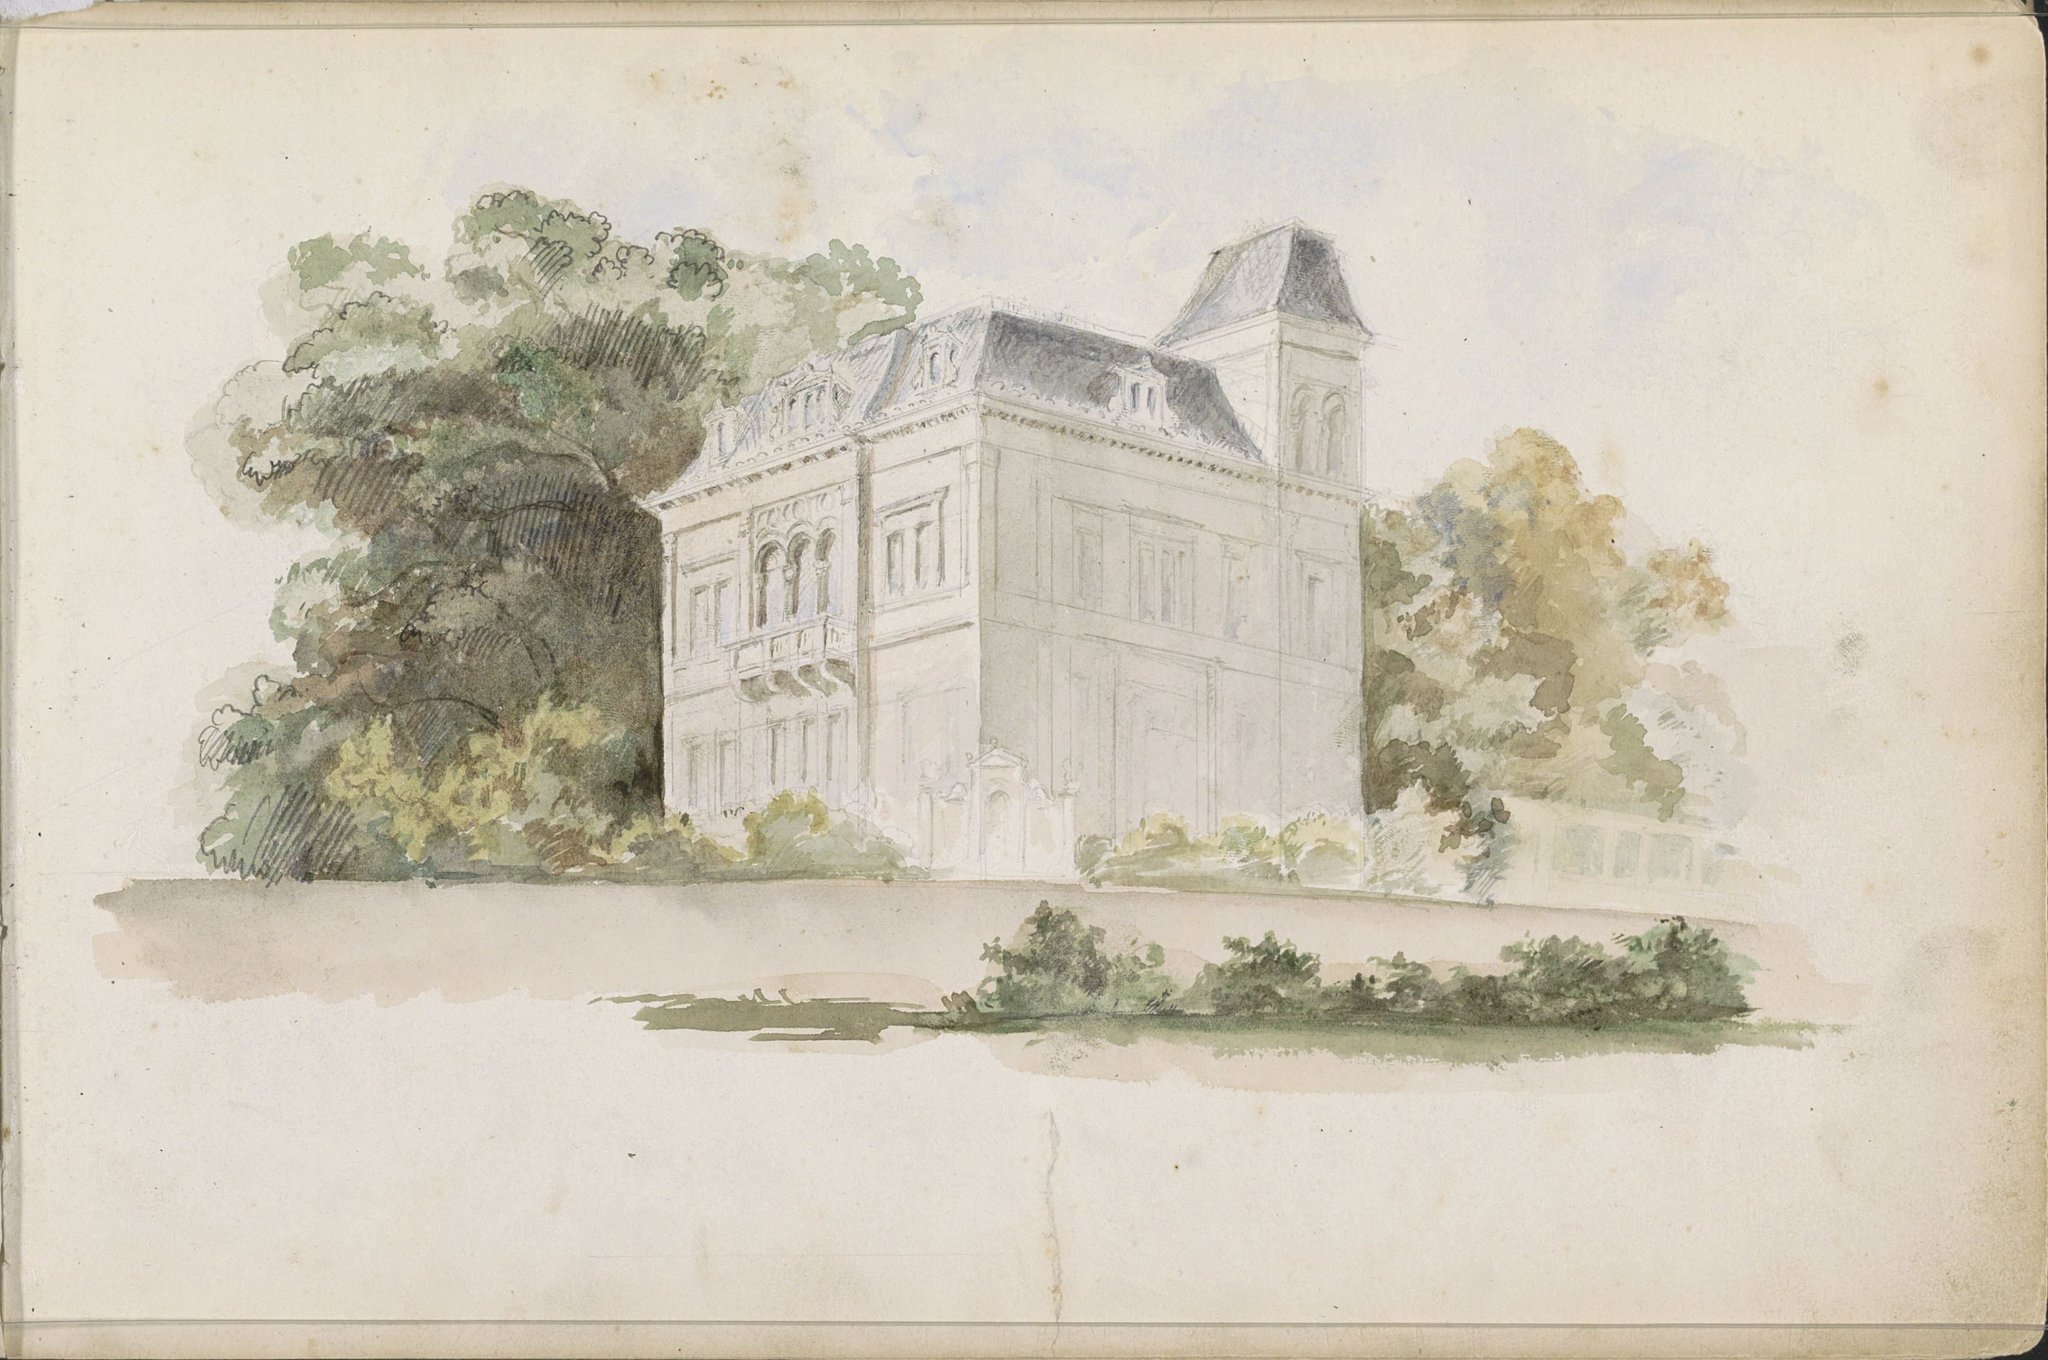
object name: sketchbook leaf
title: Vrijstaande villa met toren in een boomrijke omgeving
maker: isaac gosschalk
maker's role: draughtsman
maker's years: 1838-1907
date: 1862-1867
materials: paper, pencil, watercolor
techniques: brush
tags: country-house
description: Blad 4 recto uit een schetsboek met 58 bladen.